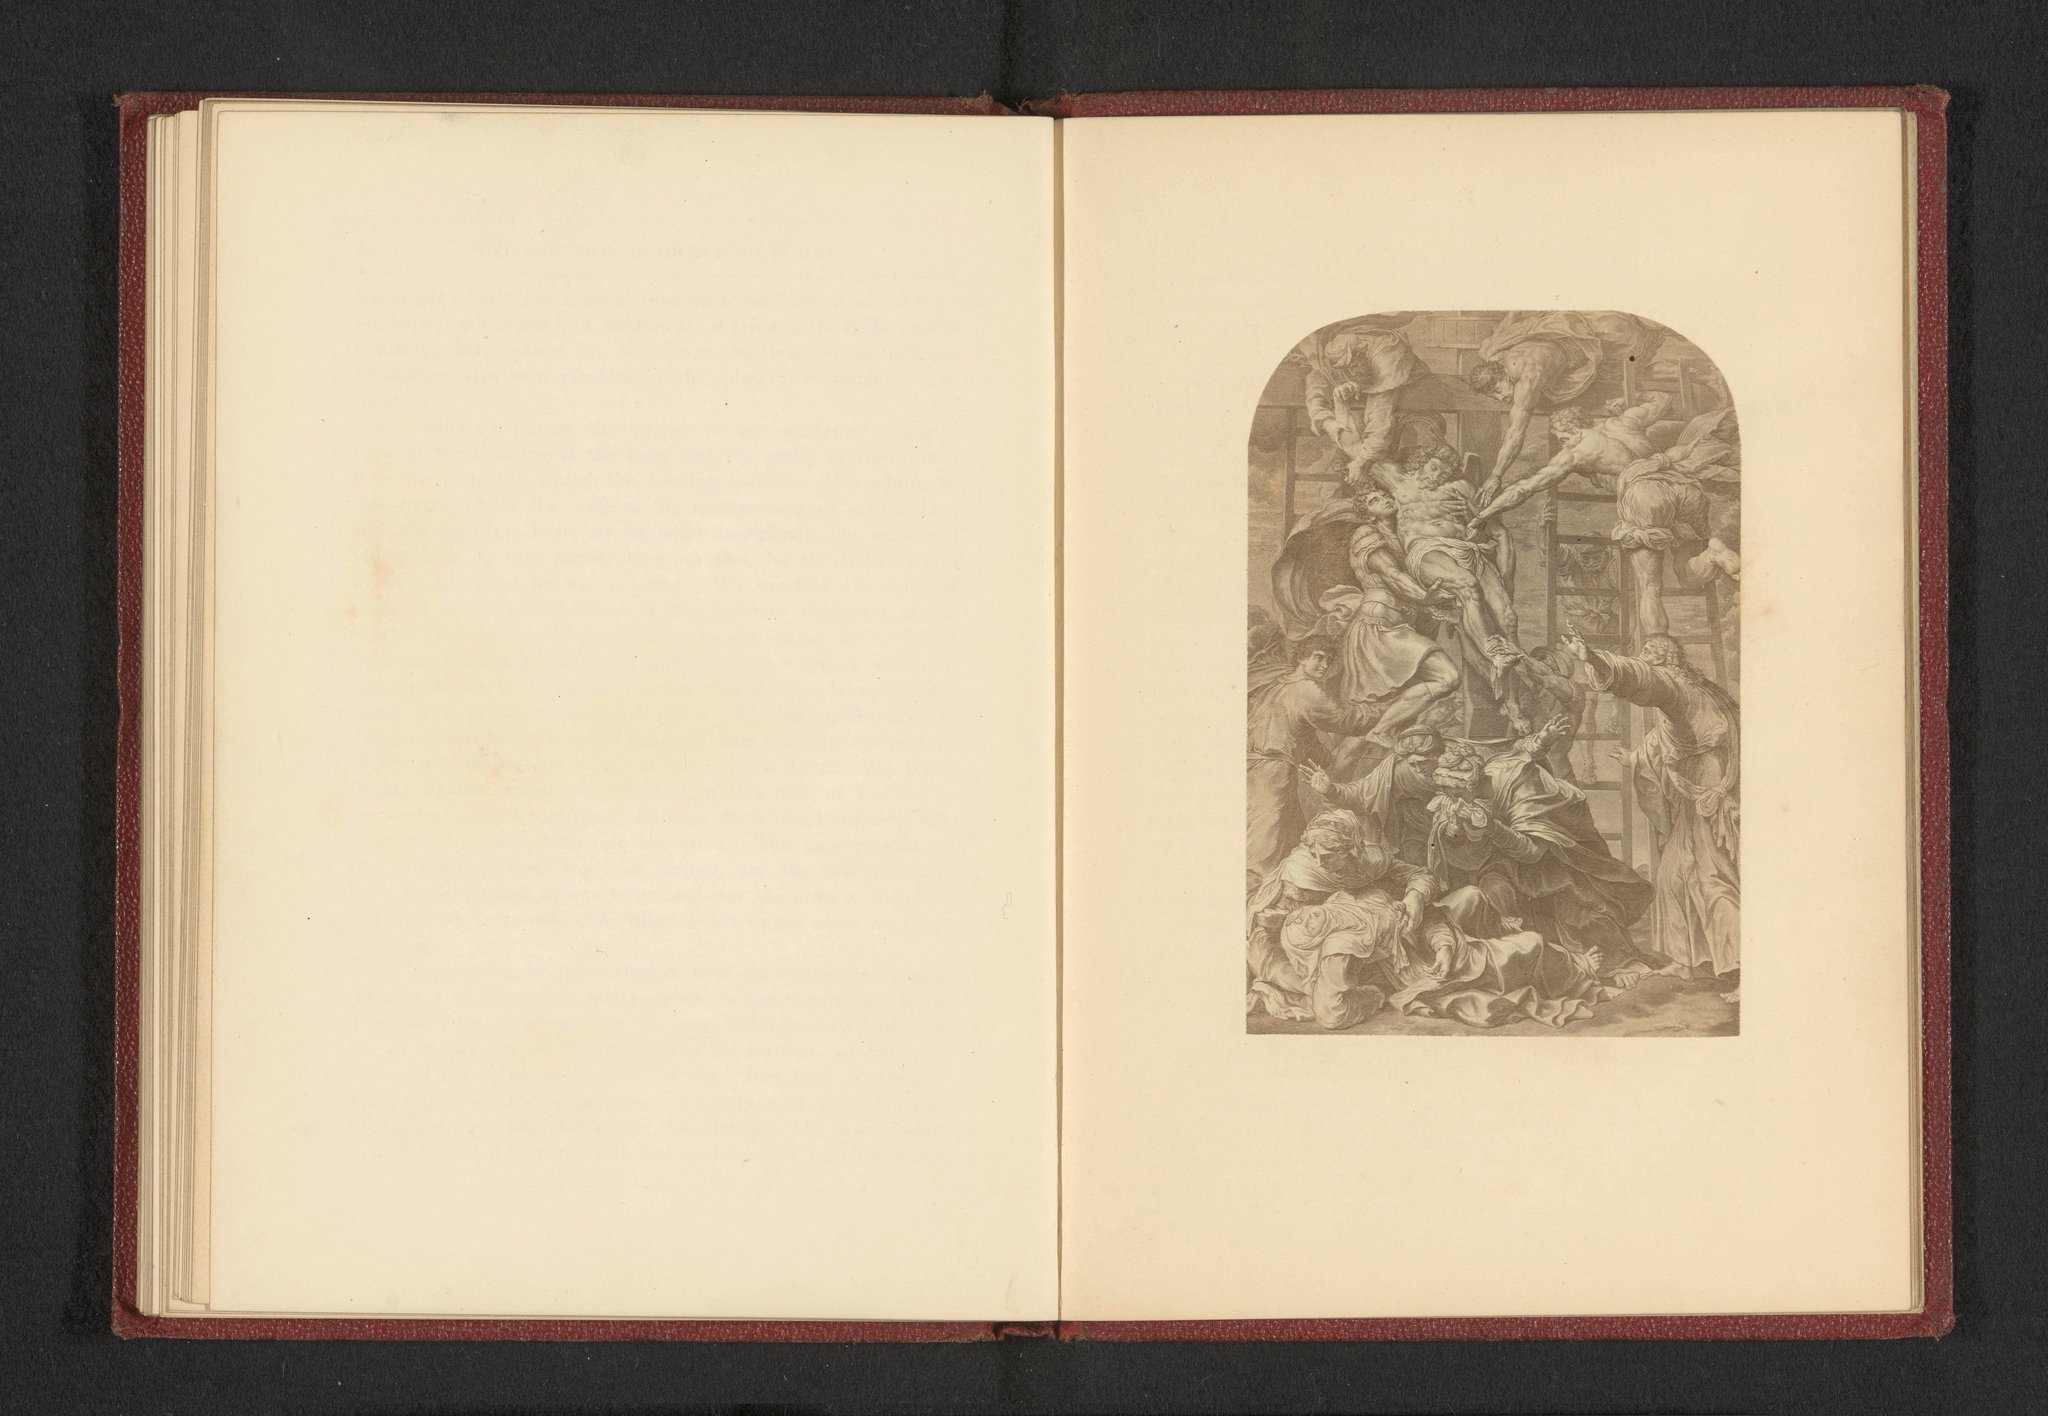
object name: photograph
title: Fotoreproductie van een prent naar een schilderij, voorstellende de Kruisafname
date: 1853-1863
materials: photographic support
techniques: albumen print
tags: descent from the cross: christ is taken down from the cross, usually by nicodemus and joseph of arimathaea who are standing on the ladders (both arms of christ detached)